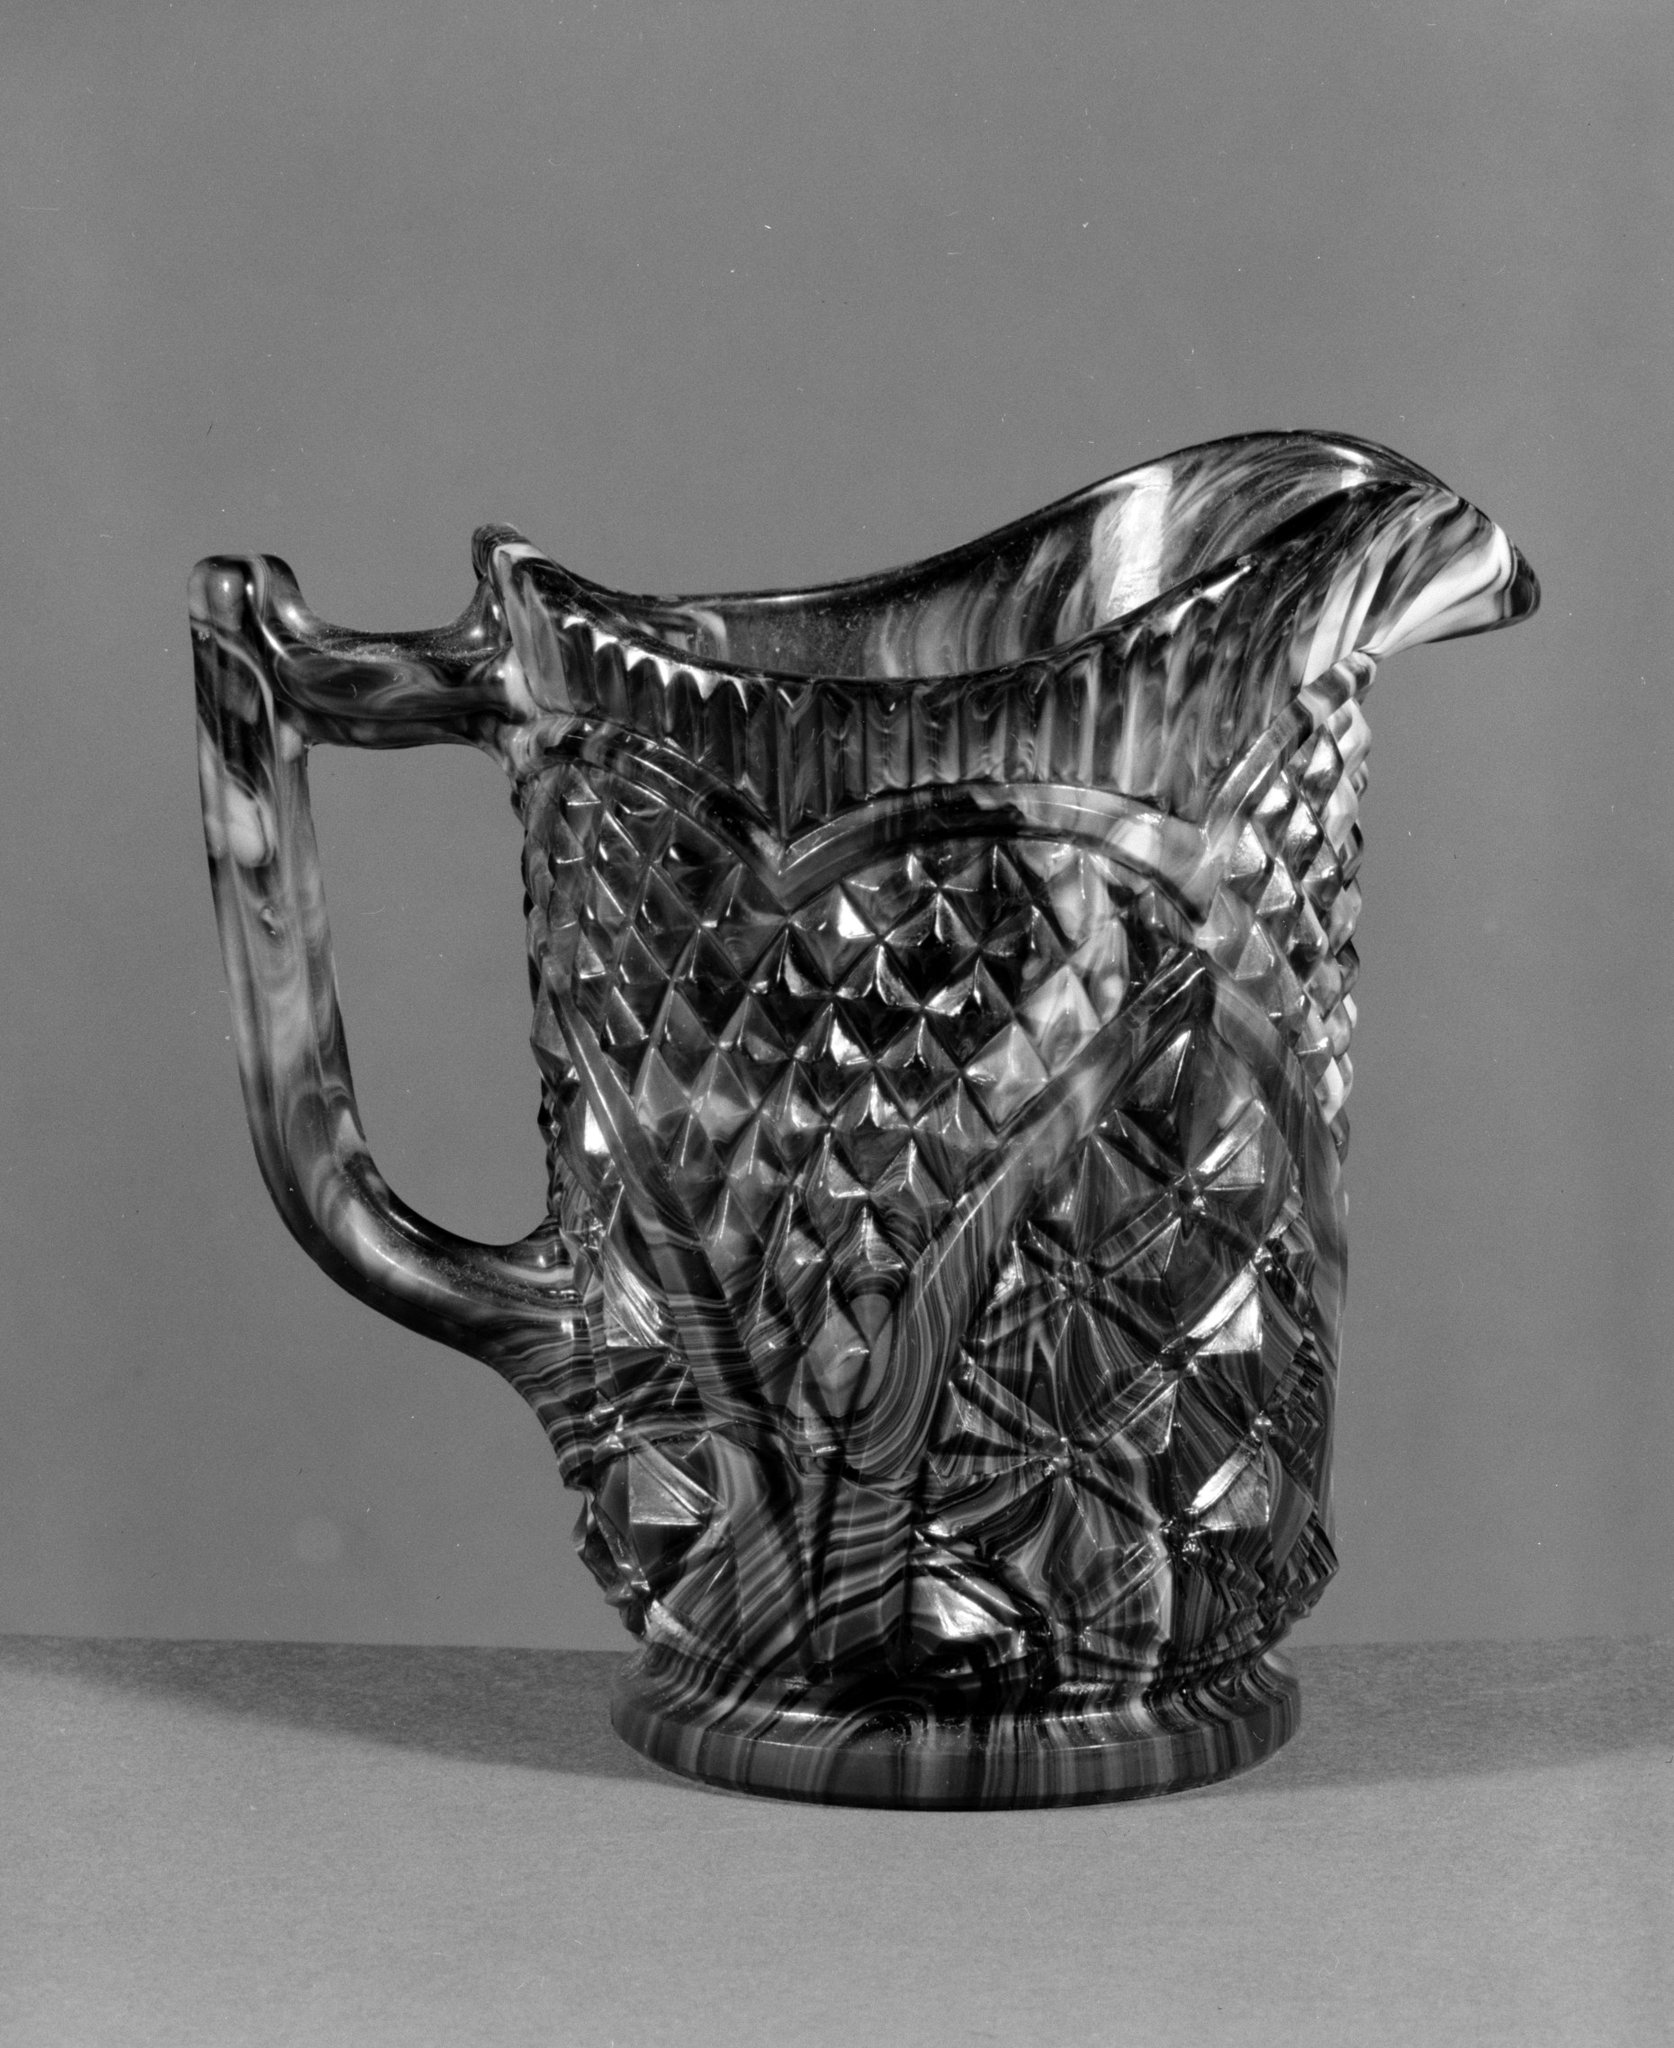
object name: cream pot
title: Creamer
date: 1880-1890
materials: glass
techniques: pressed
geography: england